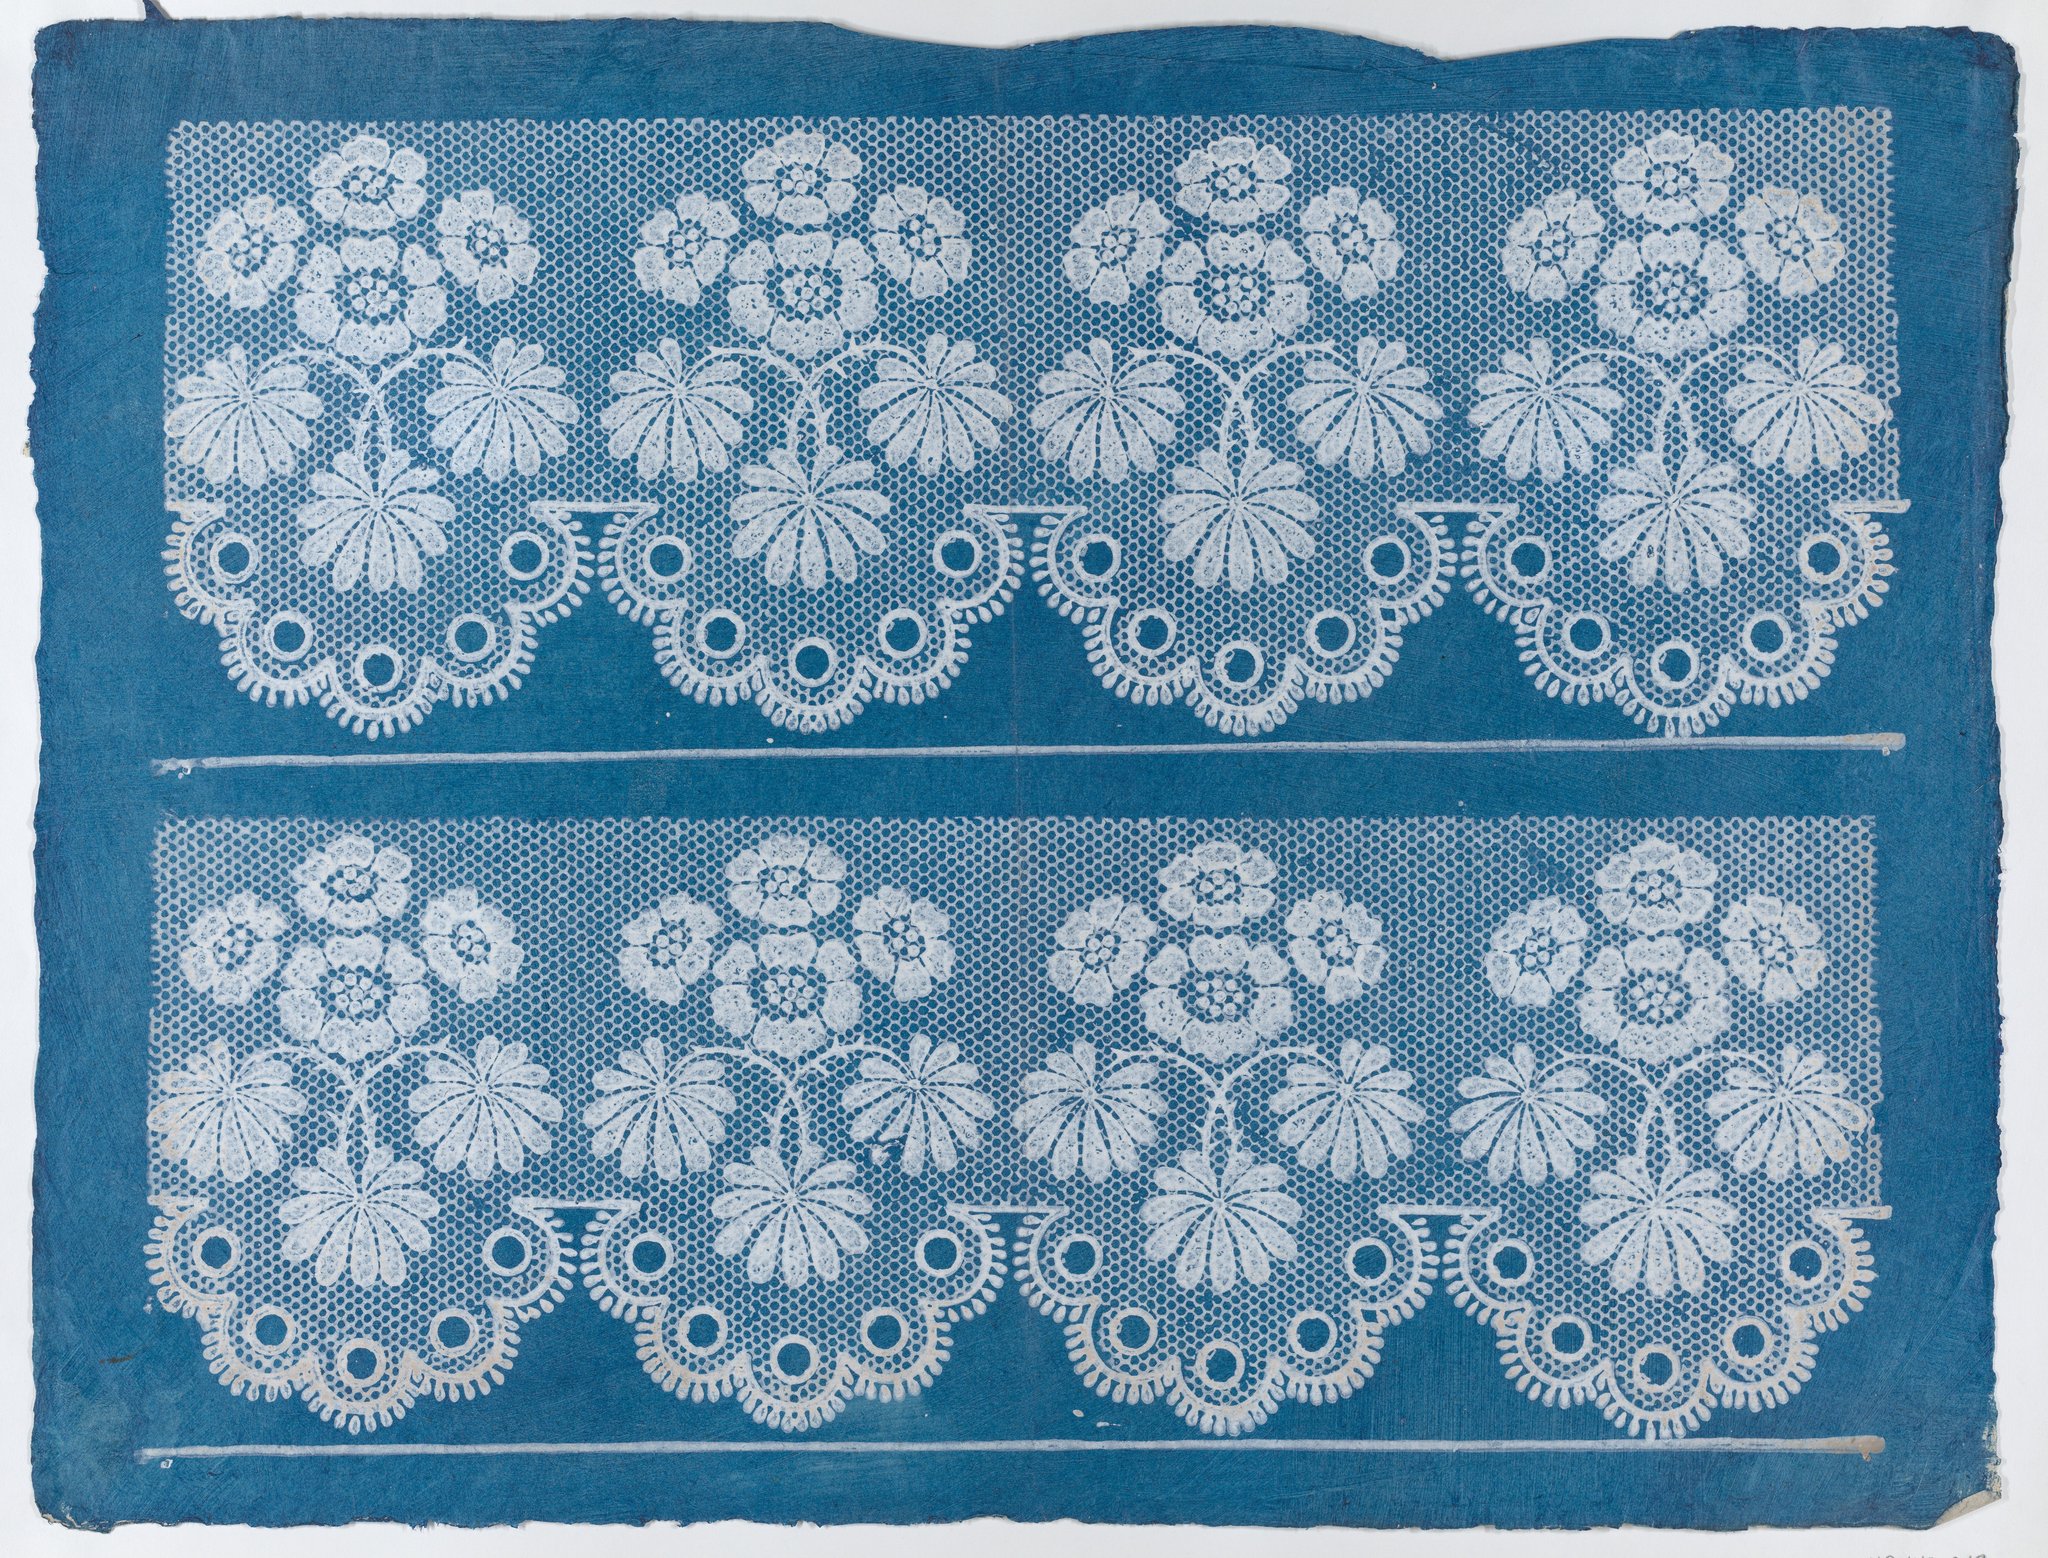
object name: print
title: Blue sheet with two borders with a white floral and lace pattern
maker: Anonymous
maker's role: artist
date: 1767-1866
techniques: relief print